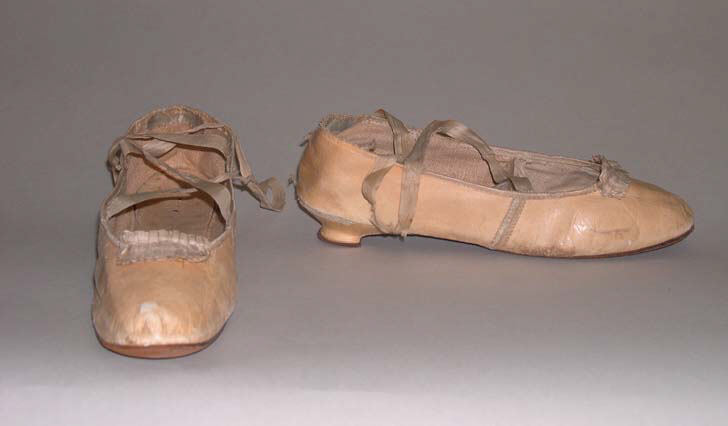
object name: wedding slipper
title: Wedding slippers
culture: american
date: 1812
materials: leather